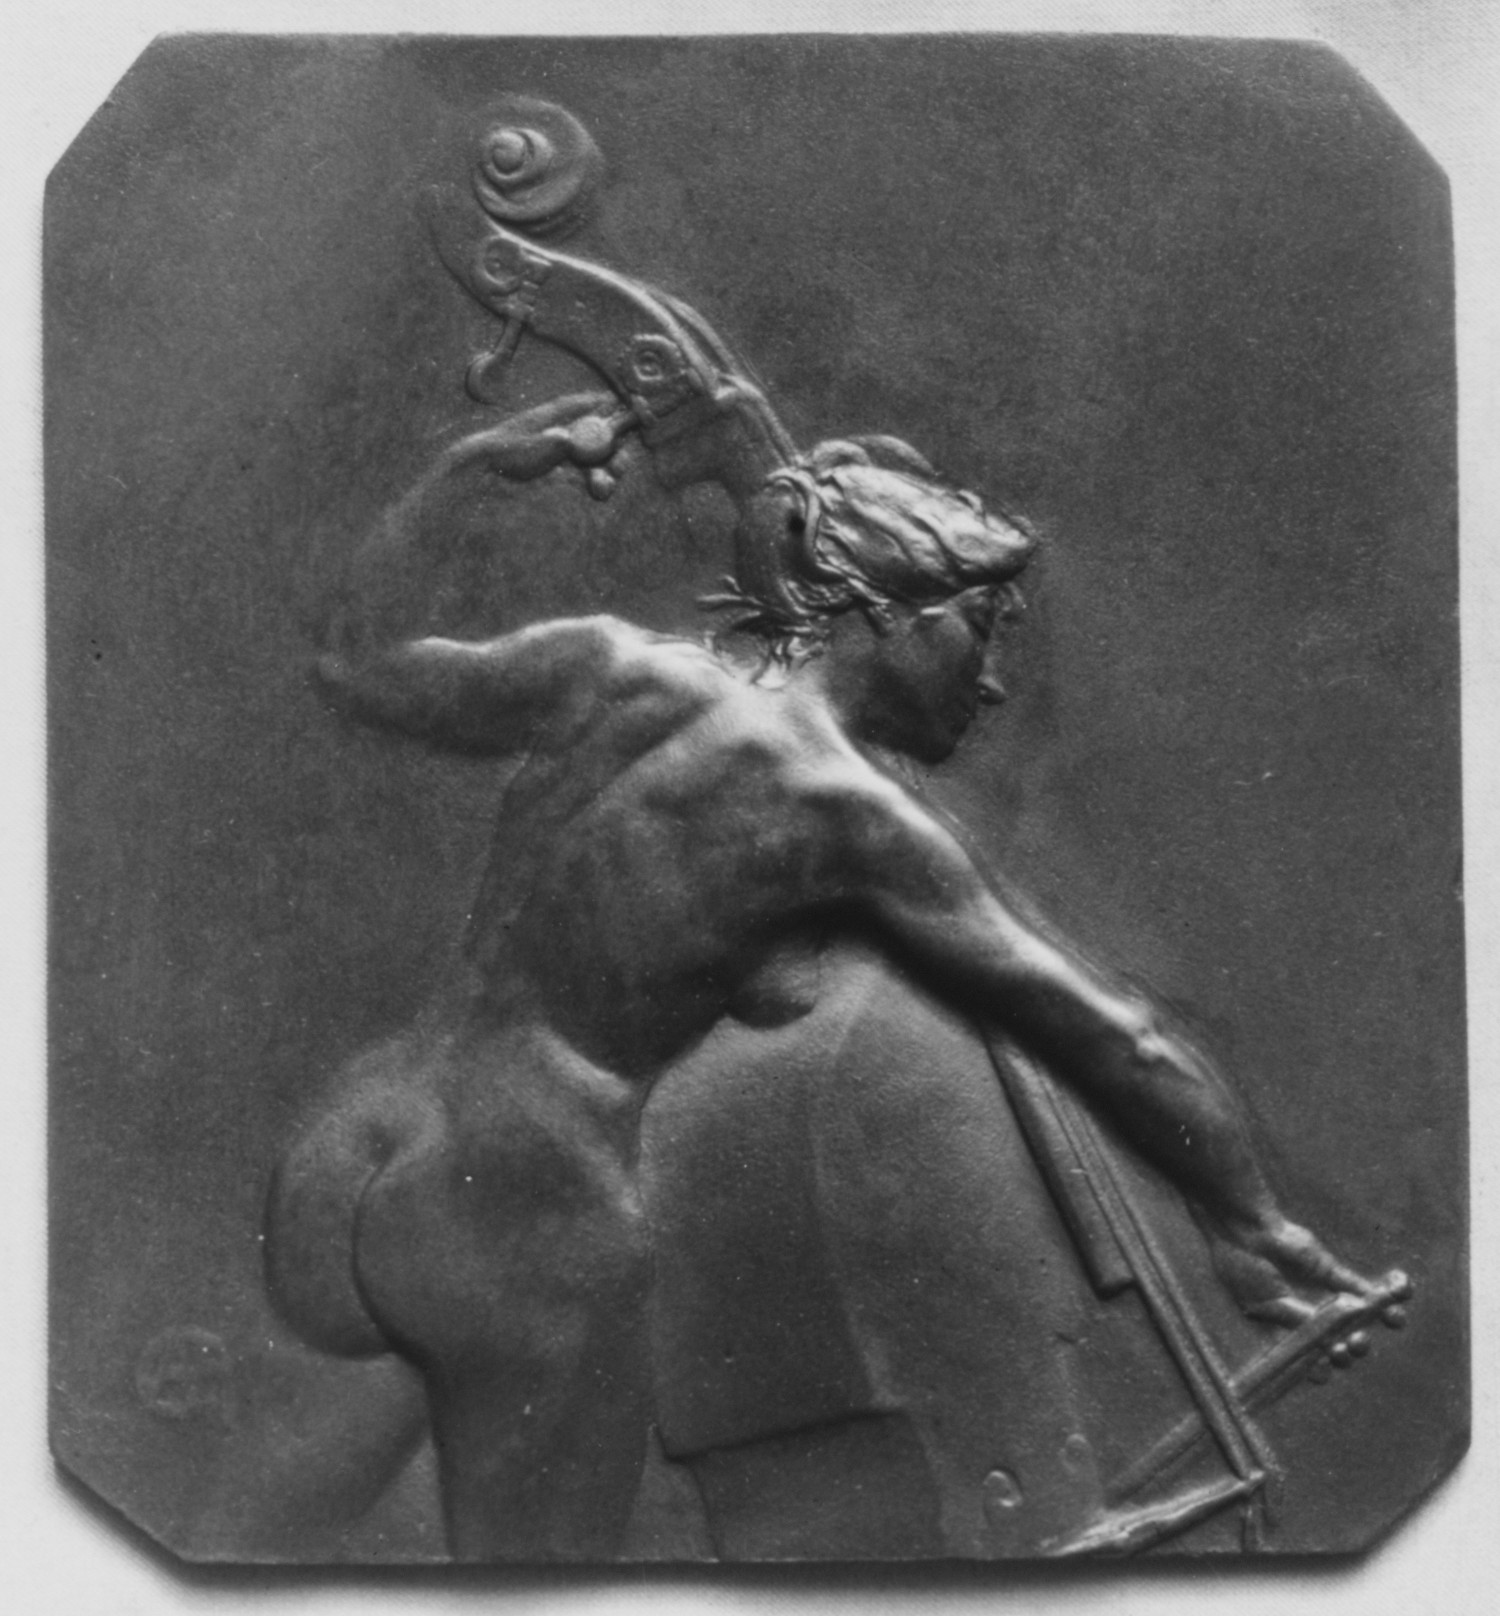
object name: plaquette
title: Female figure playing the bass-viol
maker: alexandre-louis-marie charpentier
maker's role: artist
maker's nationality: french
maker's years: 1856-1909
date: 1903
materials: bronze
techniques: casting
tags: female nudes,music,violas